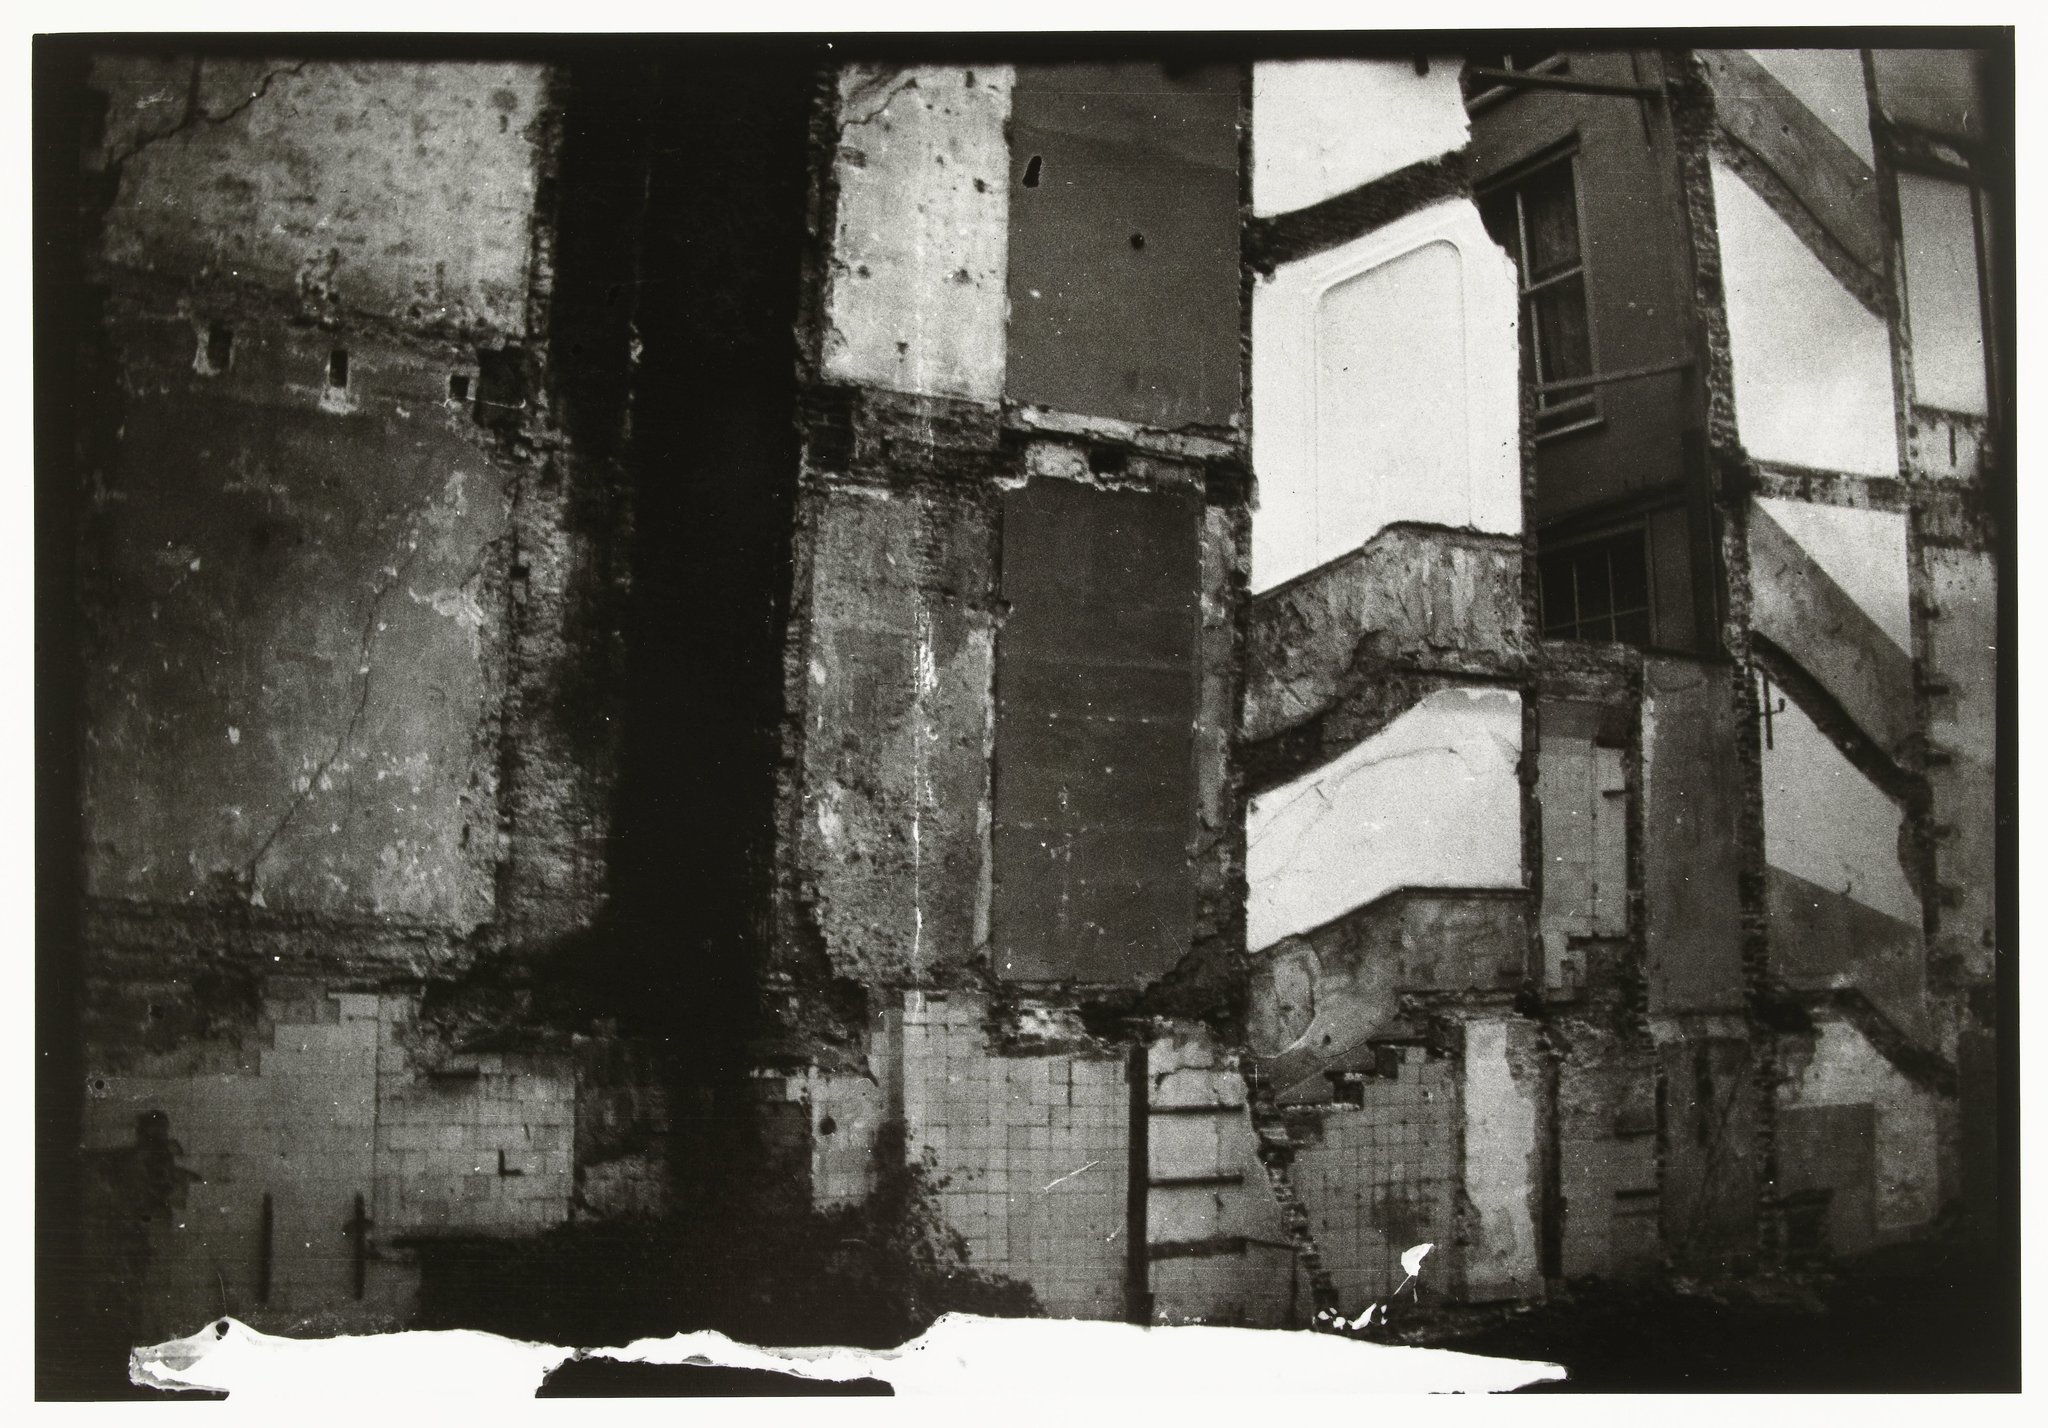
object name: photograph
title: Afbraak van panden in Amsterdam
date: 1890-1910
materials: paper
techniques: gelatin silver print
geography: netherlands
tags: amsterdam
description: Moderne afdruk van negatief BR 622 (collectie RKD).